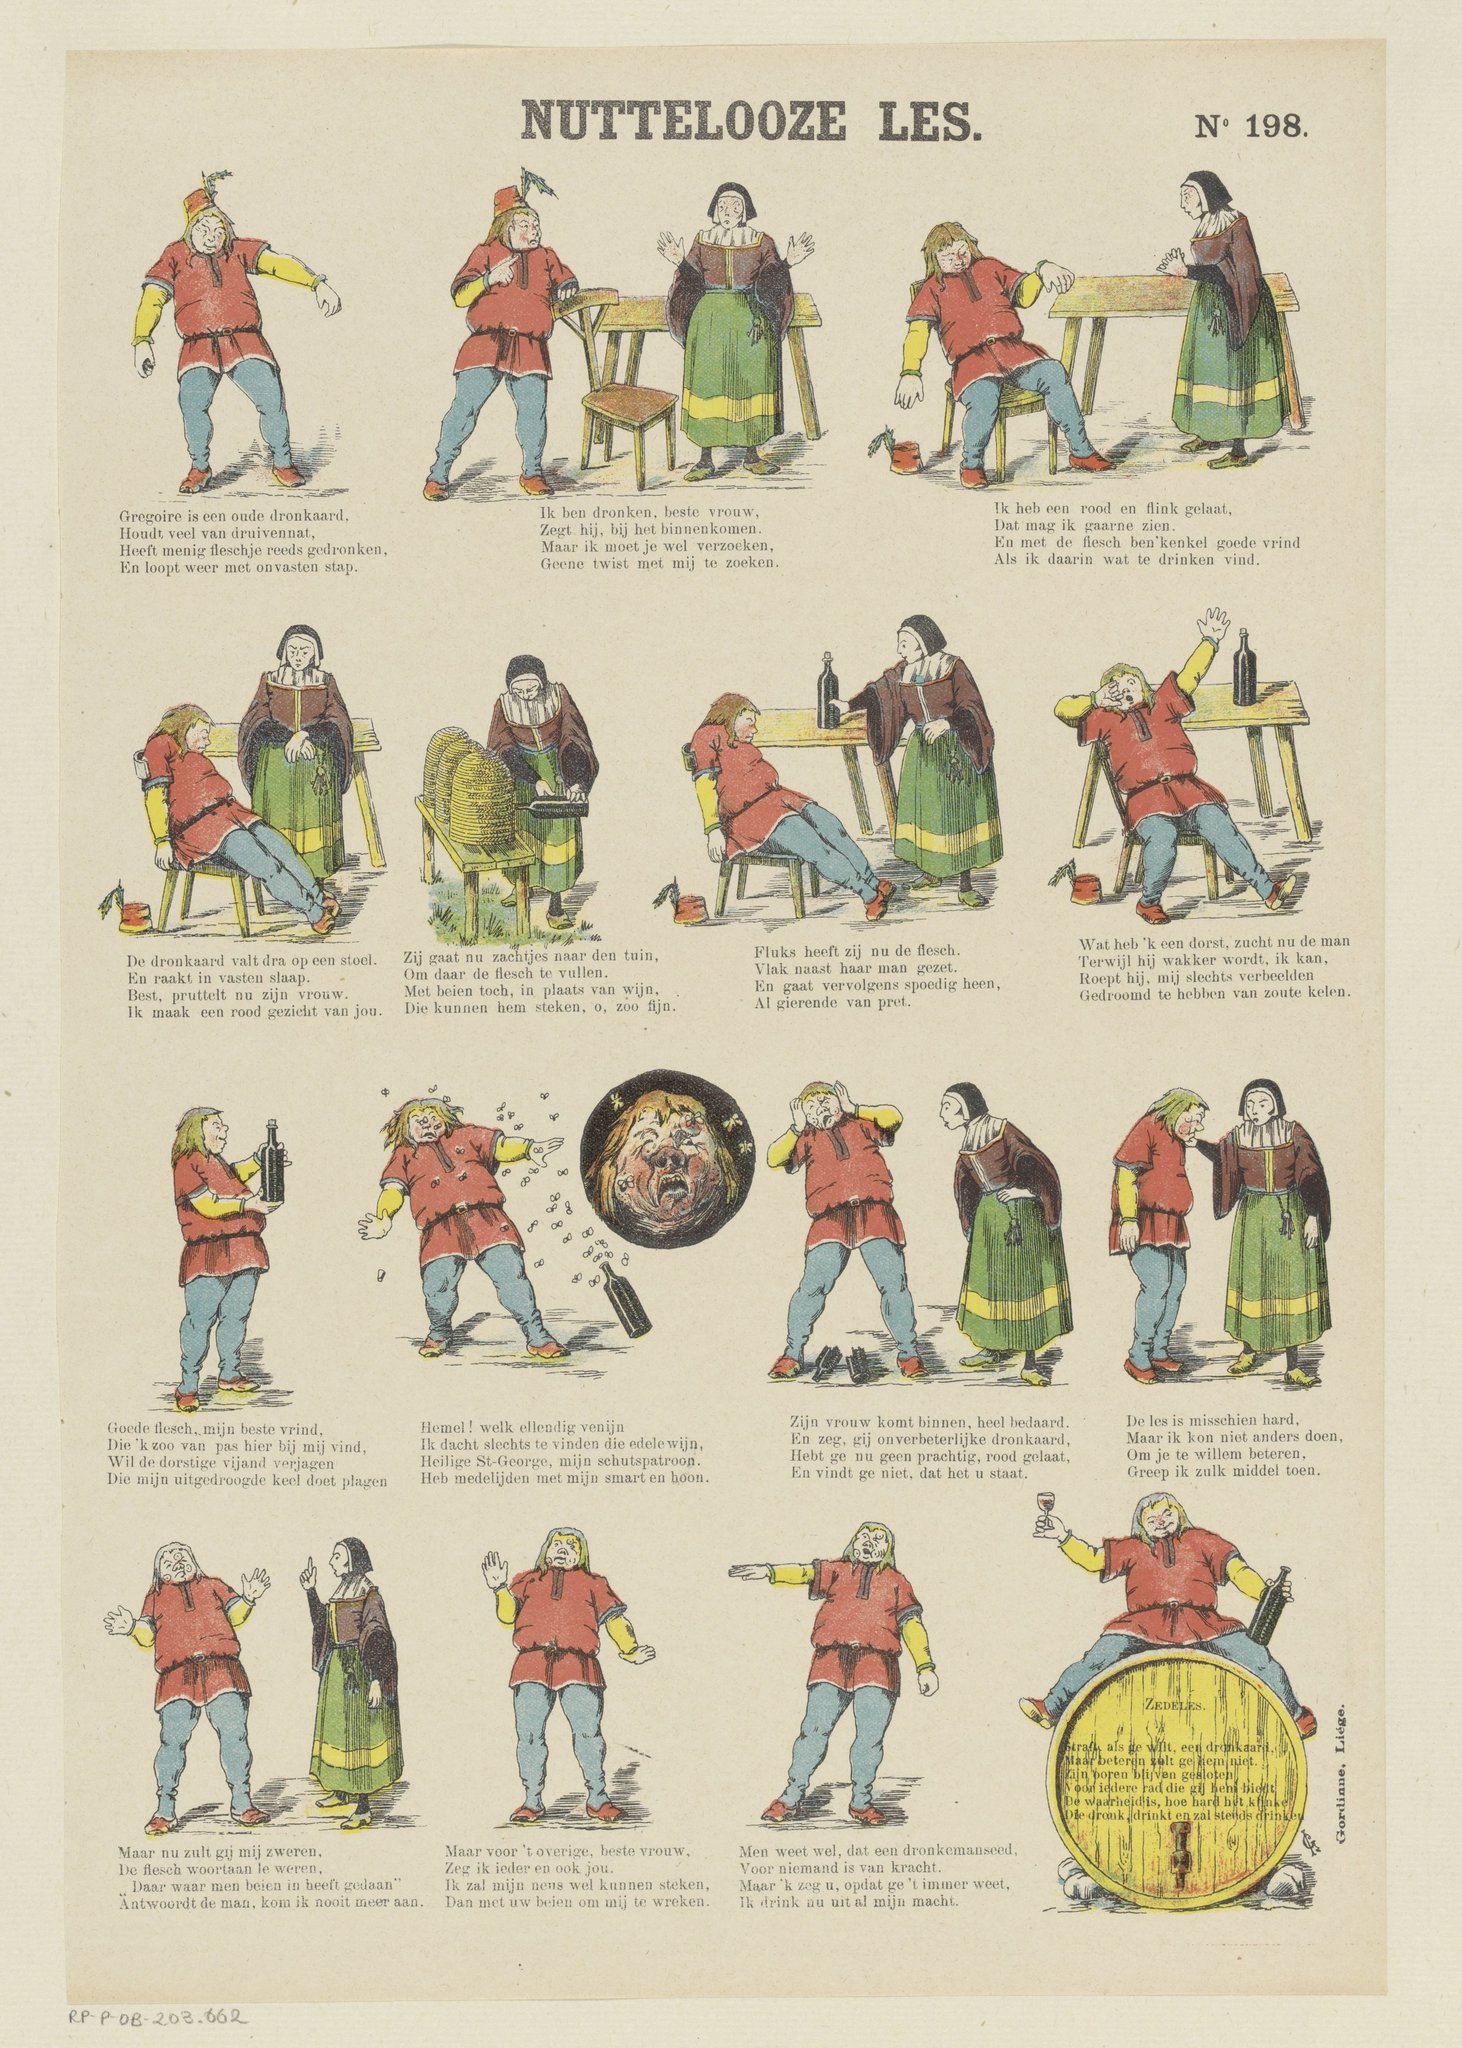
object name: print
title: Nuttelooze les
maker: monogrammist jgr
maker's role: print maker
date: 1894-1959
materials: paper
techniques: lithograph, letterpress printing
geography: liège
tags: drunkard, drunkenness, insects: bee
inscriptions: collector's mark: Lugt 2760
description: Blad met 15 voorstellingen over de dronken Gregoire die gestoken wordt door bijen. Onder elke afbeelding een onderschrift. Genummerd rechtsboven: No 198.